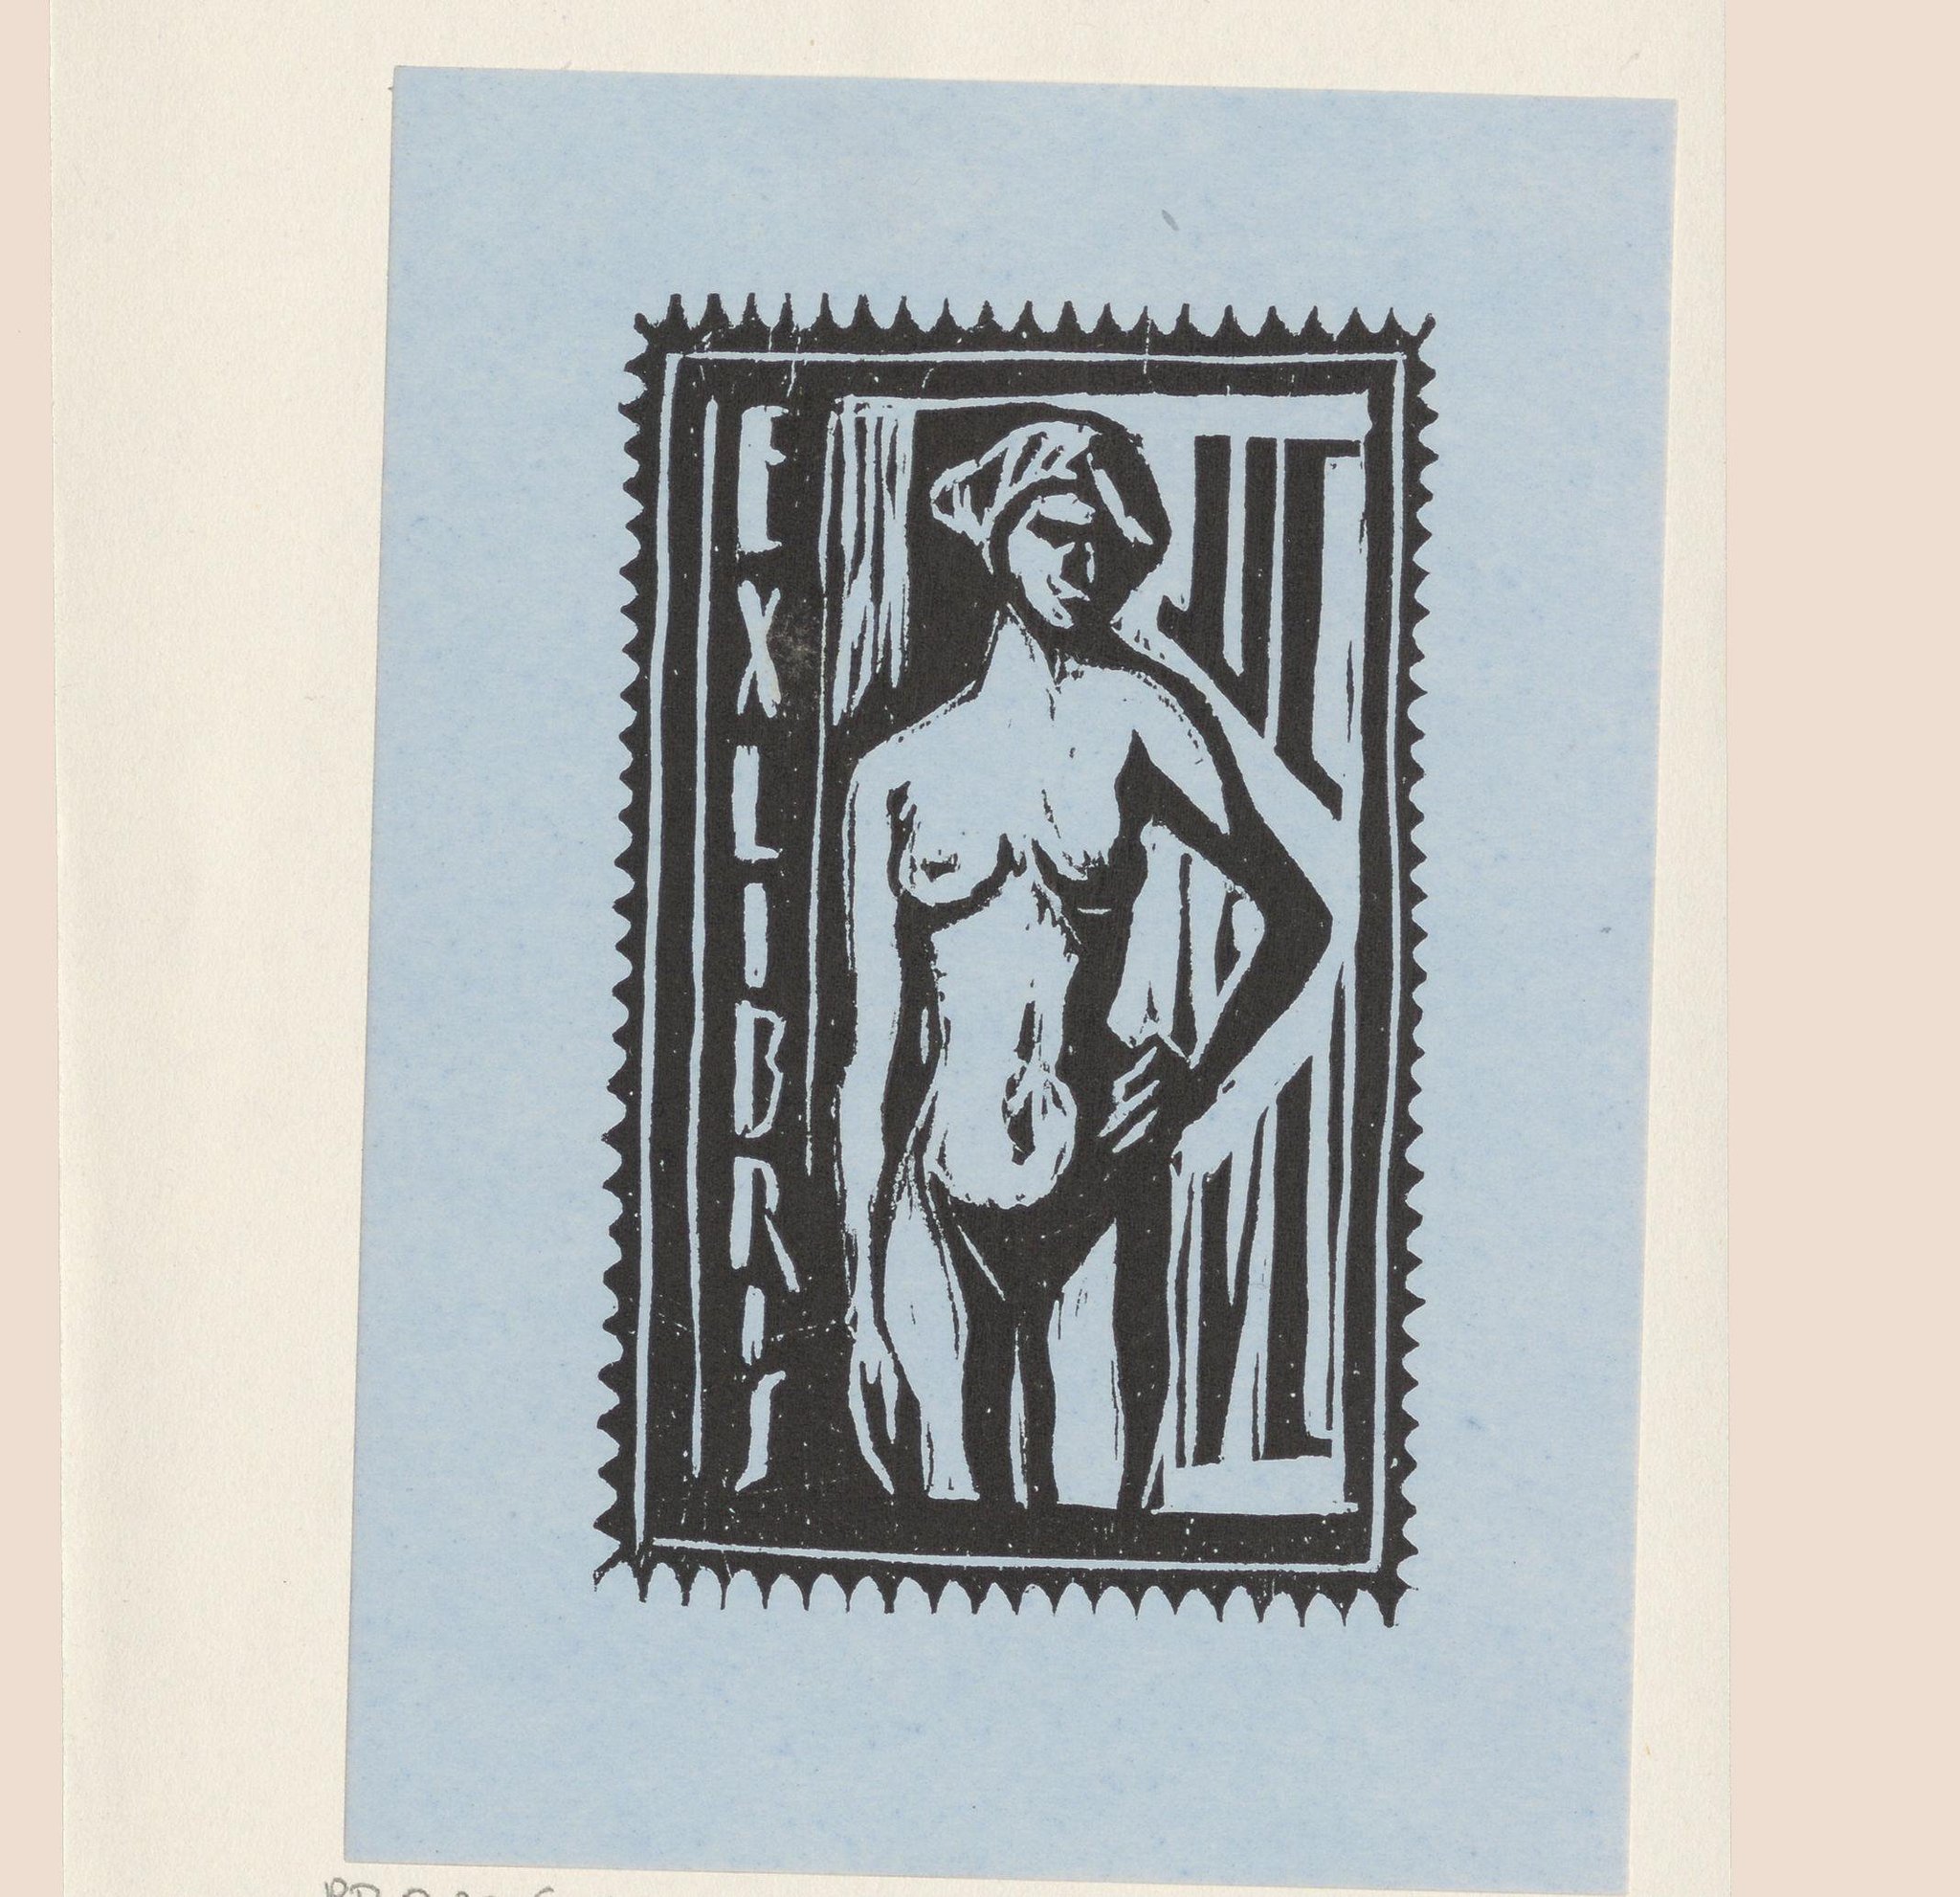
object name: bookplate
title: Ex libris van onbekend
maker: jo bezaan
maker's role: draughtsman, print maker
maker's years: 1894-1952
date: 1904-1952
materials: paper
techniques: linocut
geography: netherlands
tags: woman (showing herself) undressed, quasi-nude